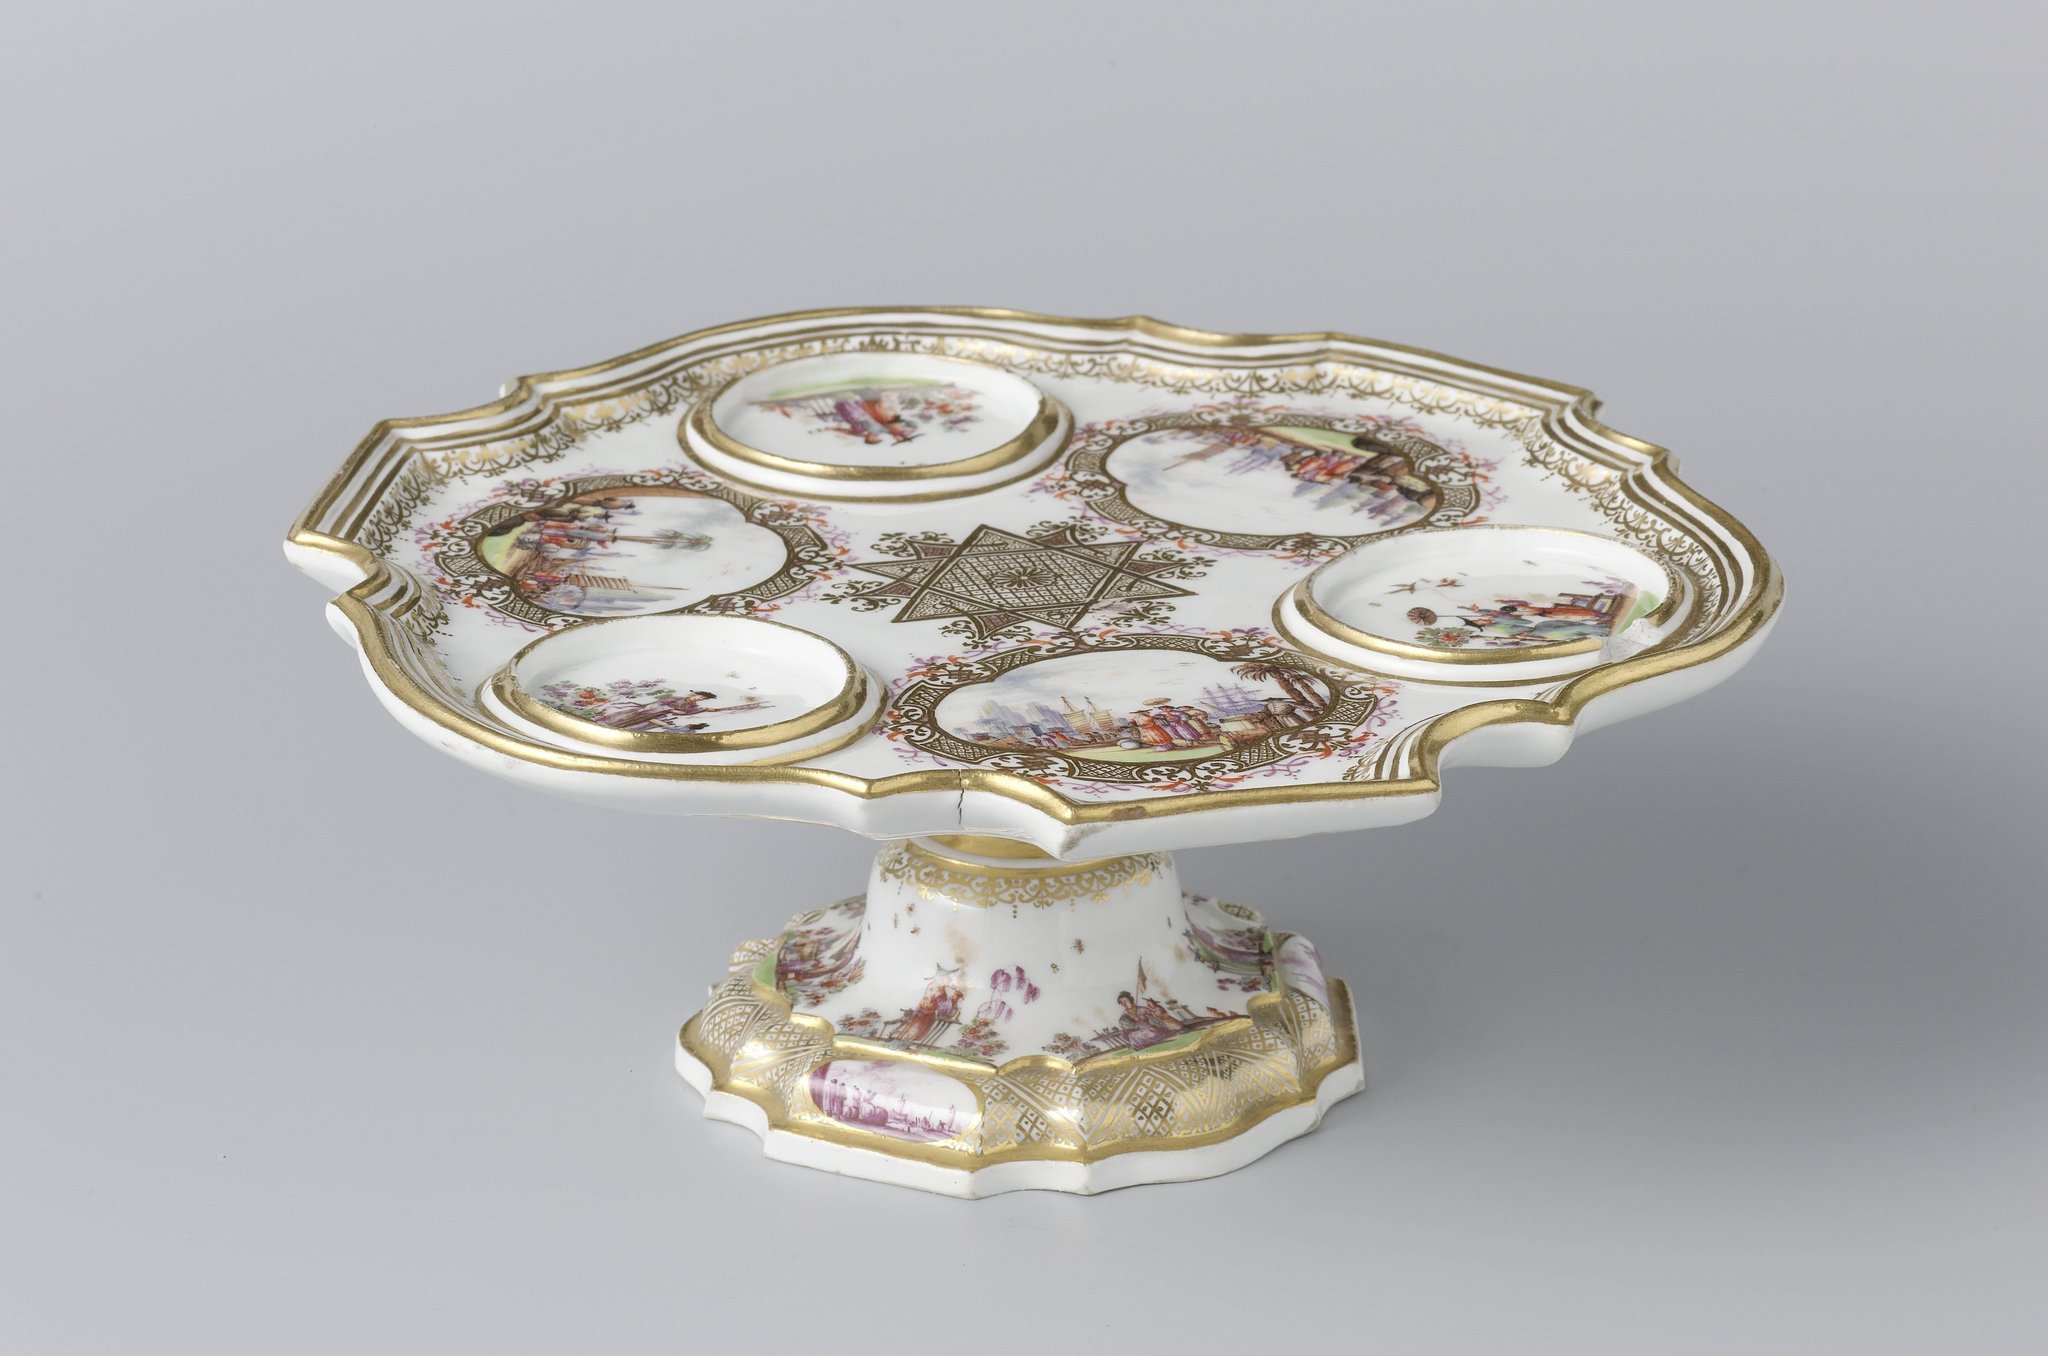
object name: dienblad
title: Chocolate set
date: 1740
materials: porcelain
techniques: painted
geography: meissen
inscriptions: factory mark, number: ‘213.’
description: Meissener Porzellan Manufaktur Meissen, c. 1740 hard-paste porcelain